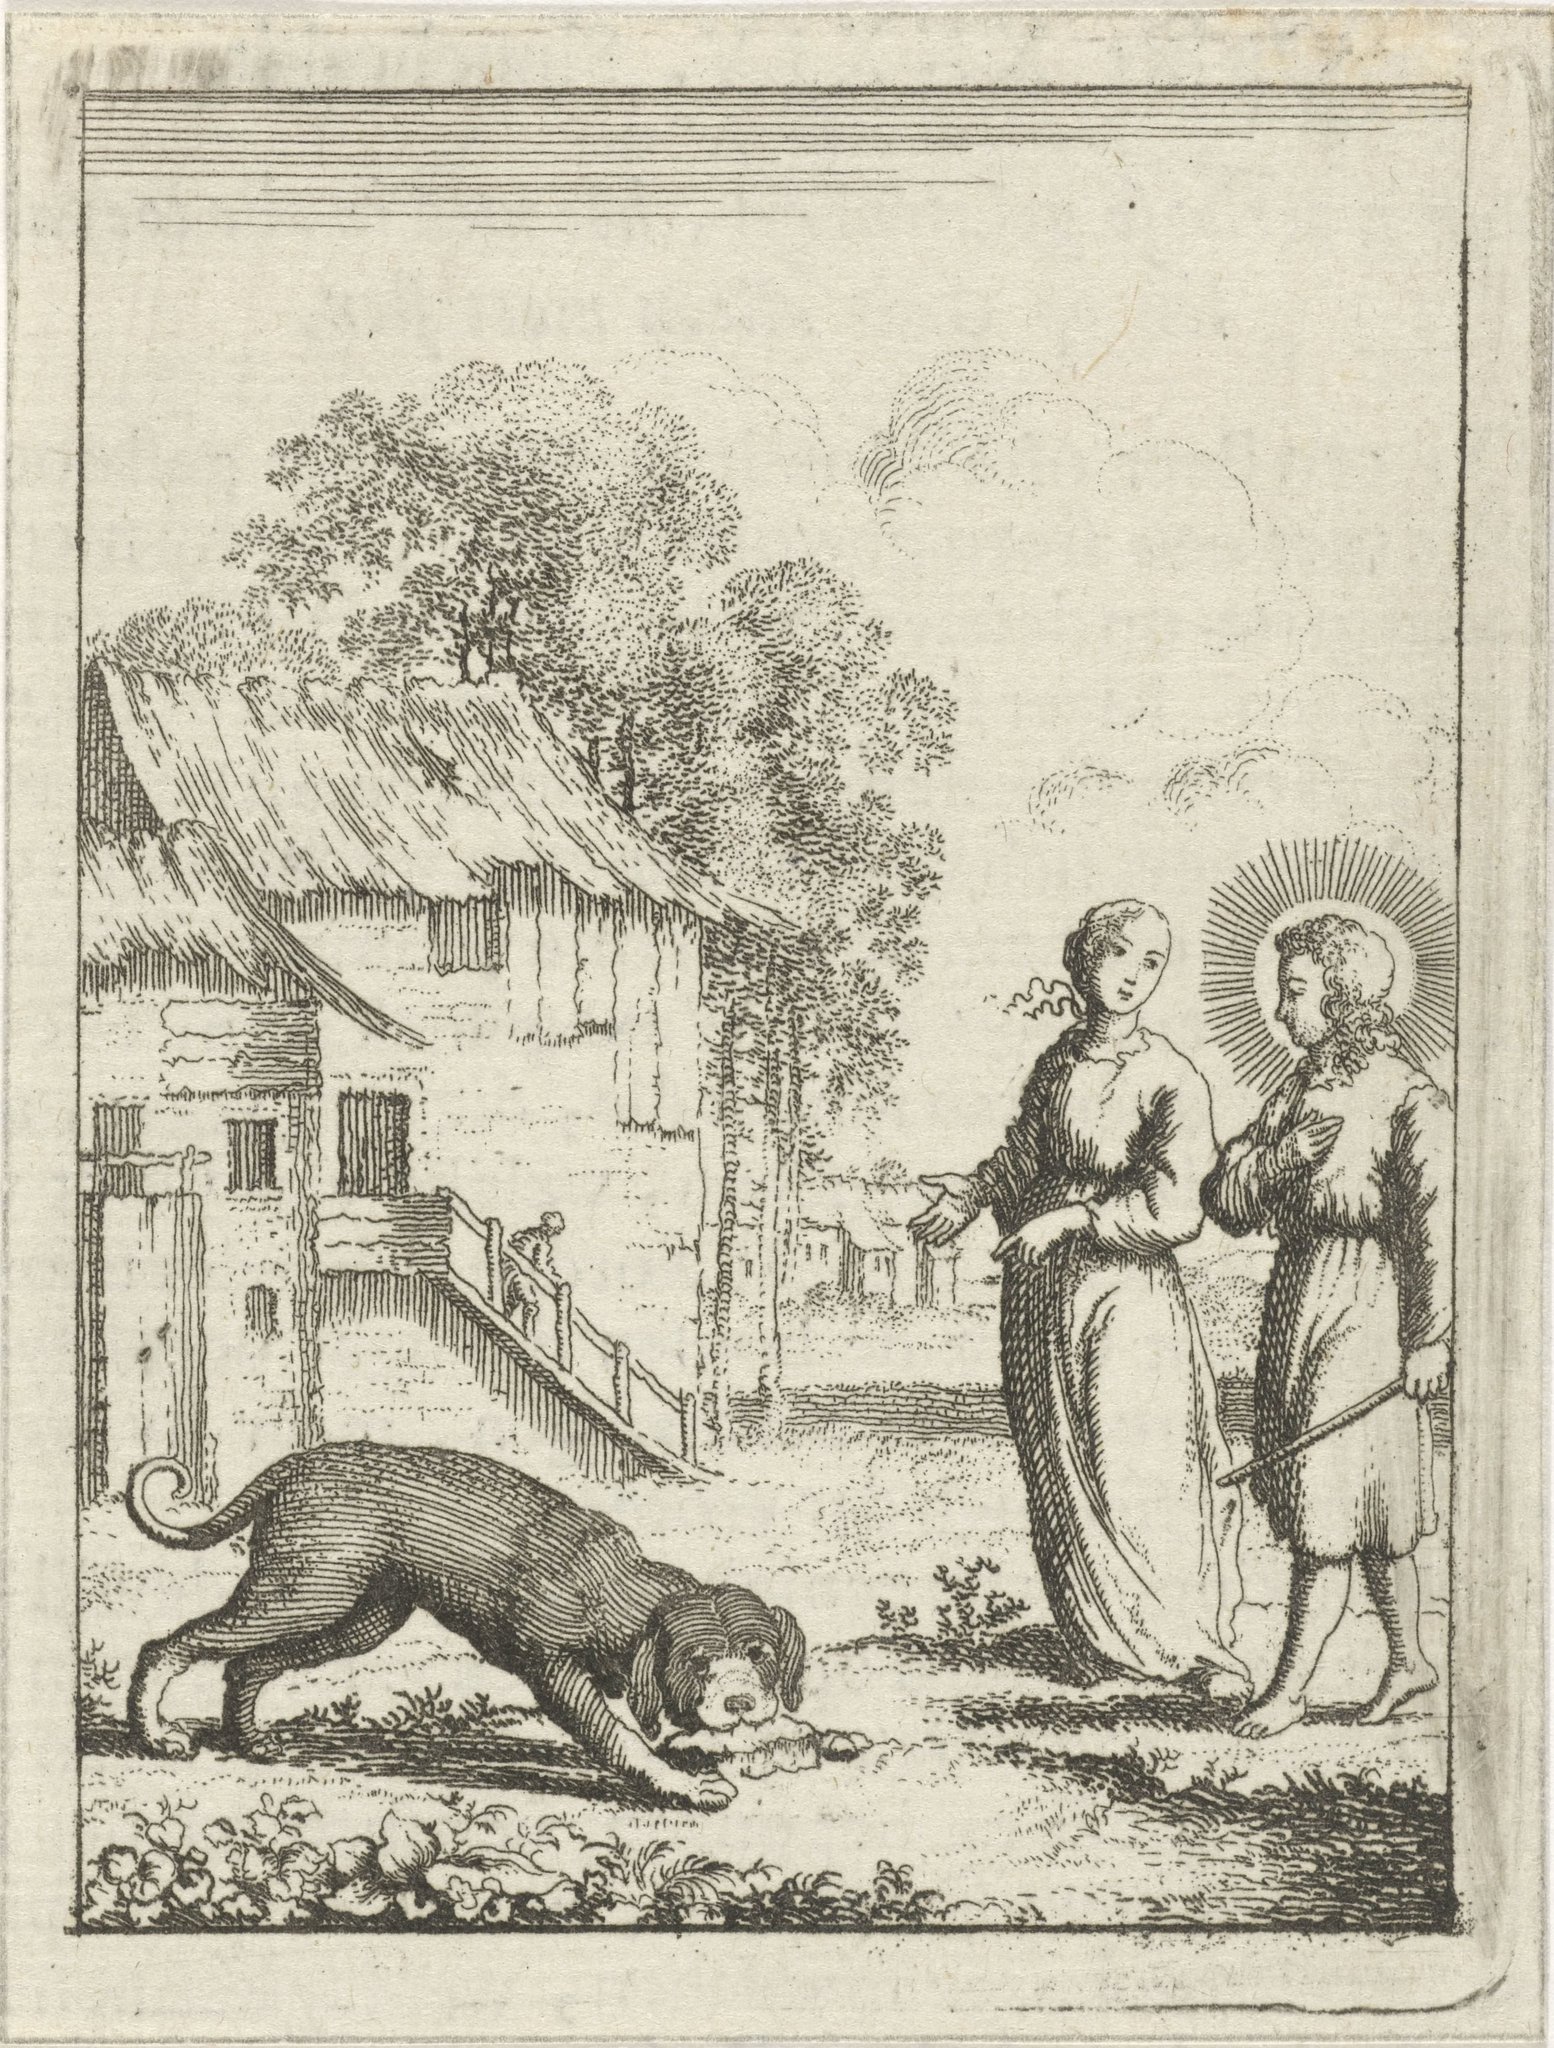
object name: book illustration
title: Jezus en de Ziel zien een hond, die op een steen bijt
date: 1678-1687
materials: paper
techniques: etching, letterpress printing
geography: amsterdam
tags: the soul, christ and the soul, dog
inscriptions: collector's mark: Lugt 2228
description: Illustratie uit: Luyken, Jan. Jezus en de Ziel, 3 delen. Amsterdam: Pieter Arentsz II, 1678-1687. Tussen 1678-1744 verschenen van dit emblemataboek 10 edities.